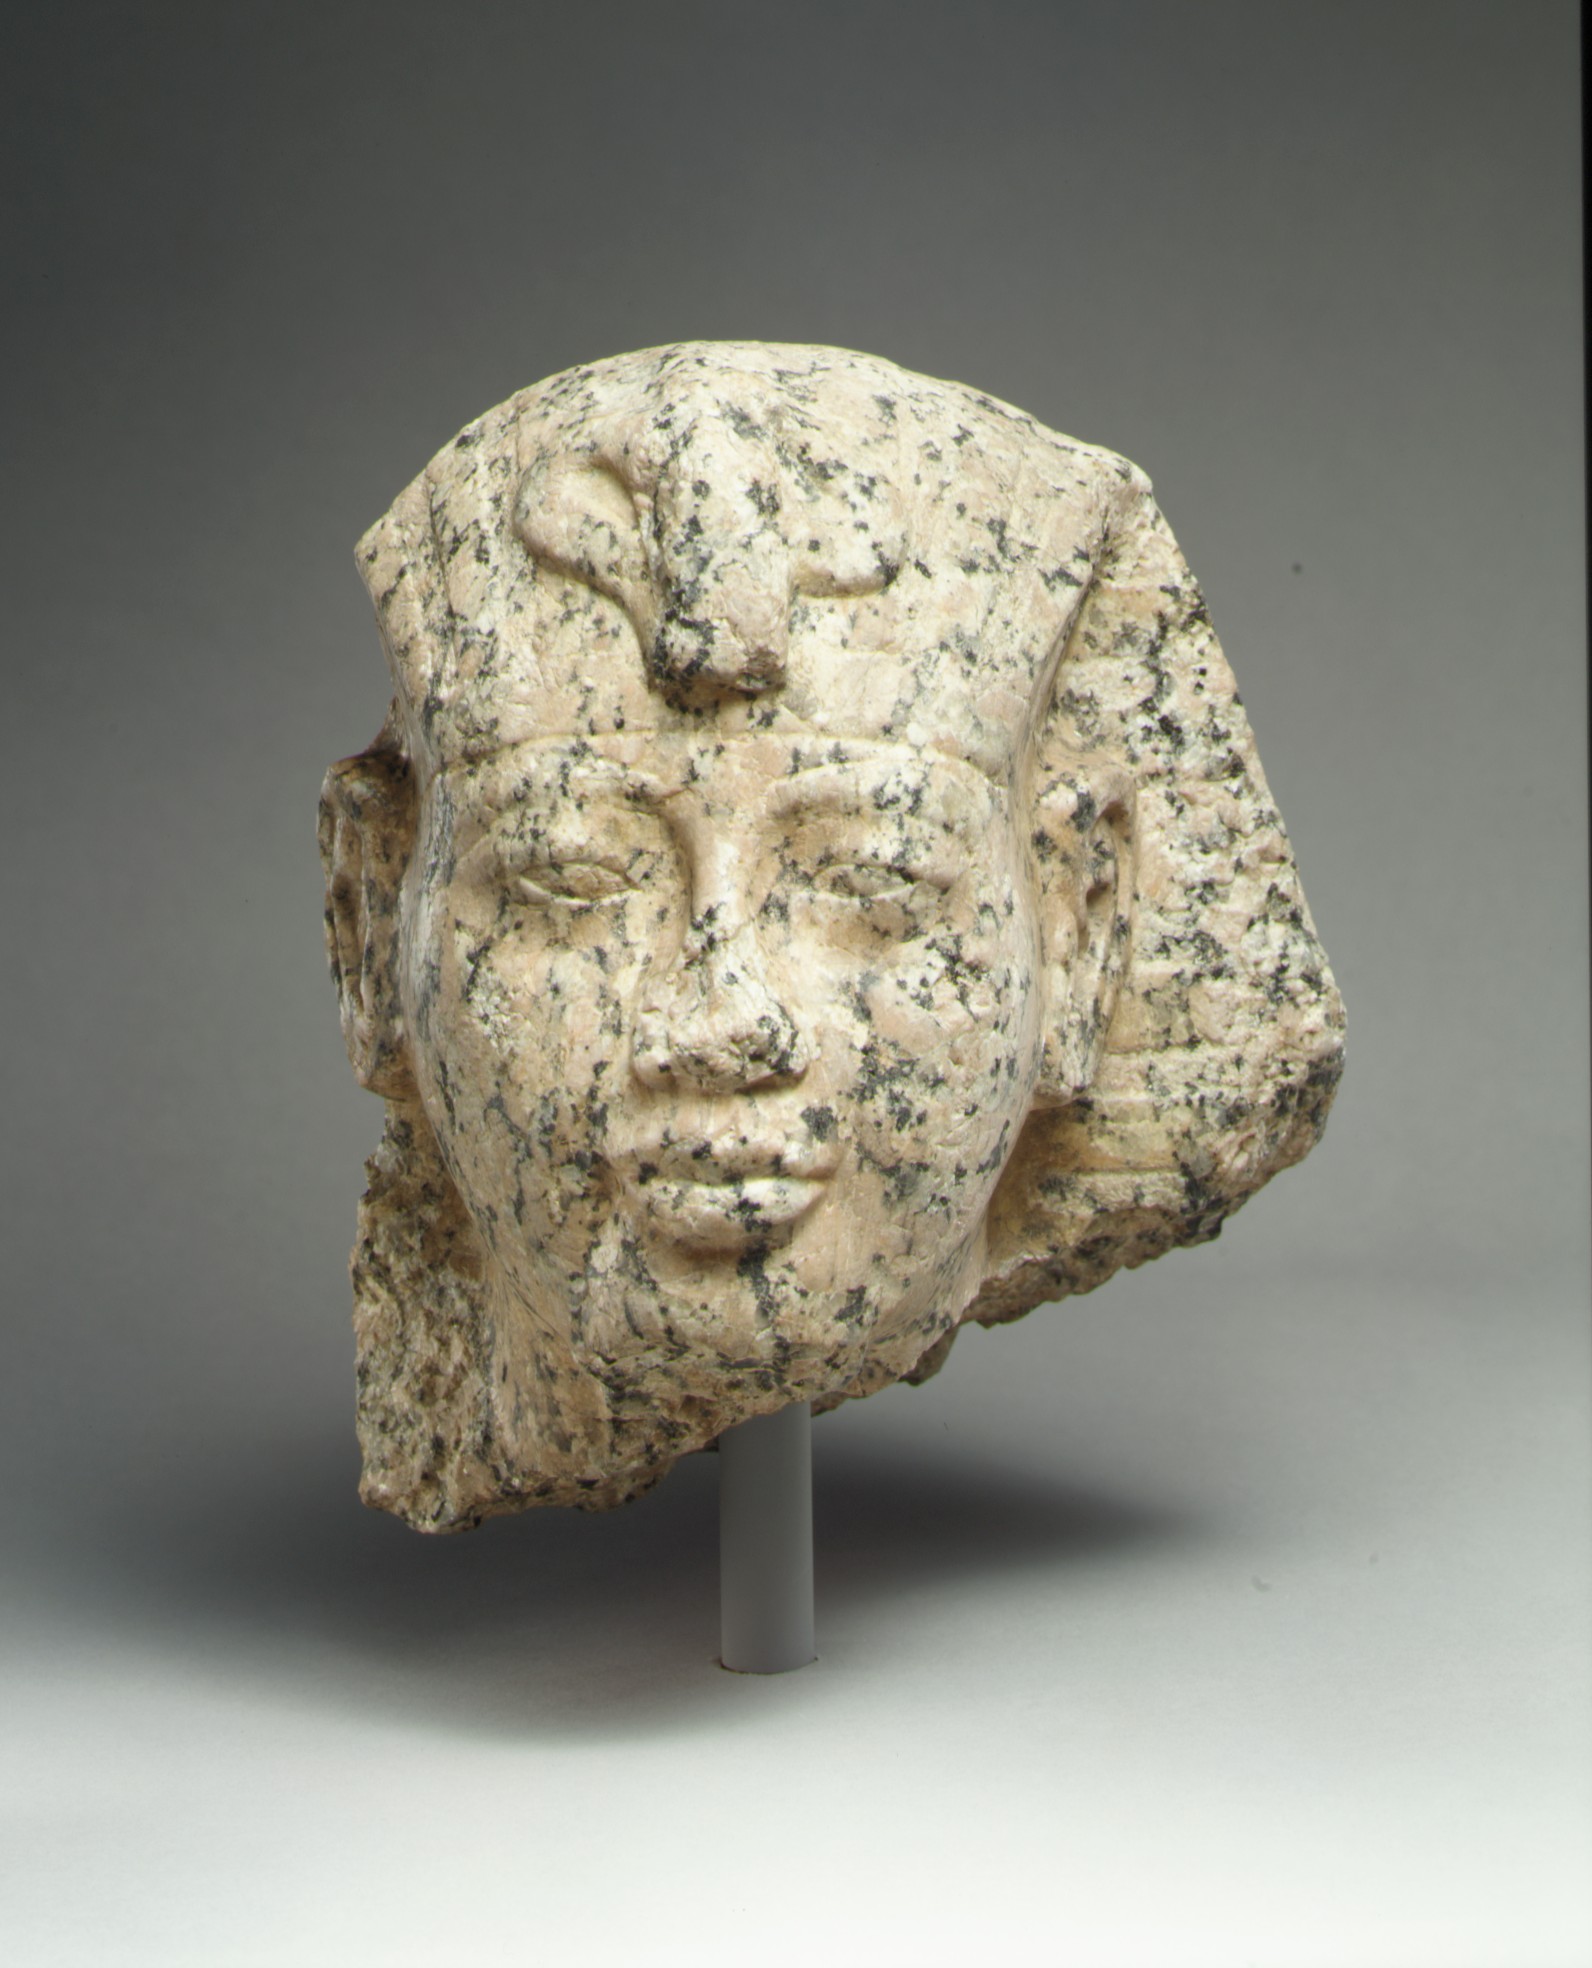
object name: head, amenhotep iii, nemes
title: Amenhotep III with nemes headdress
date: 1390-1352 BCE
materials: granite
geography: egypt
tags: heads,men